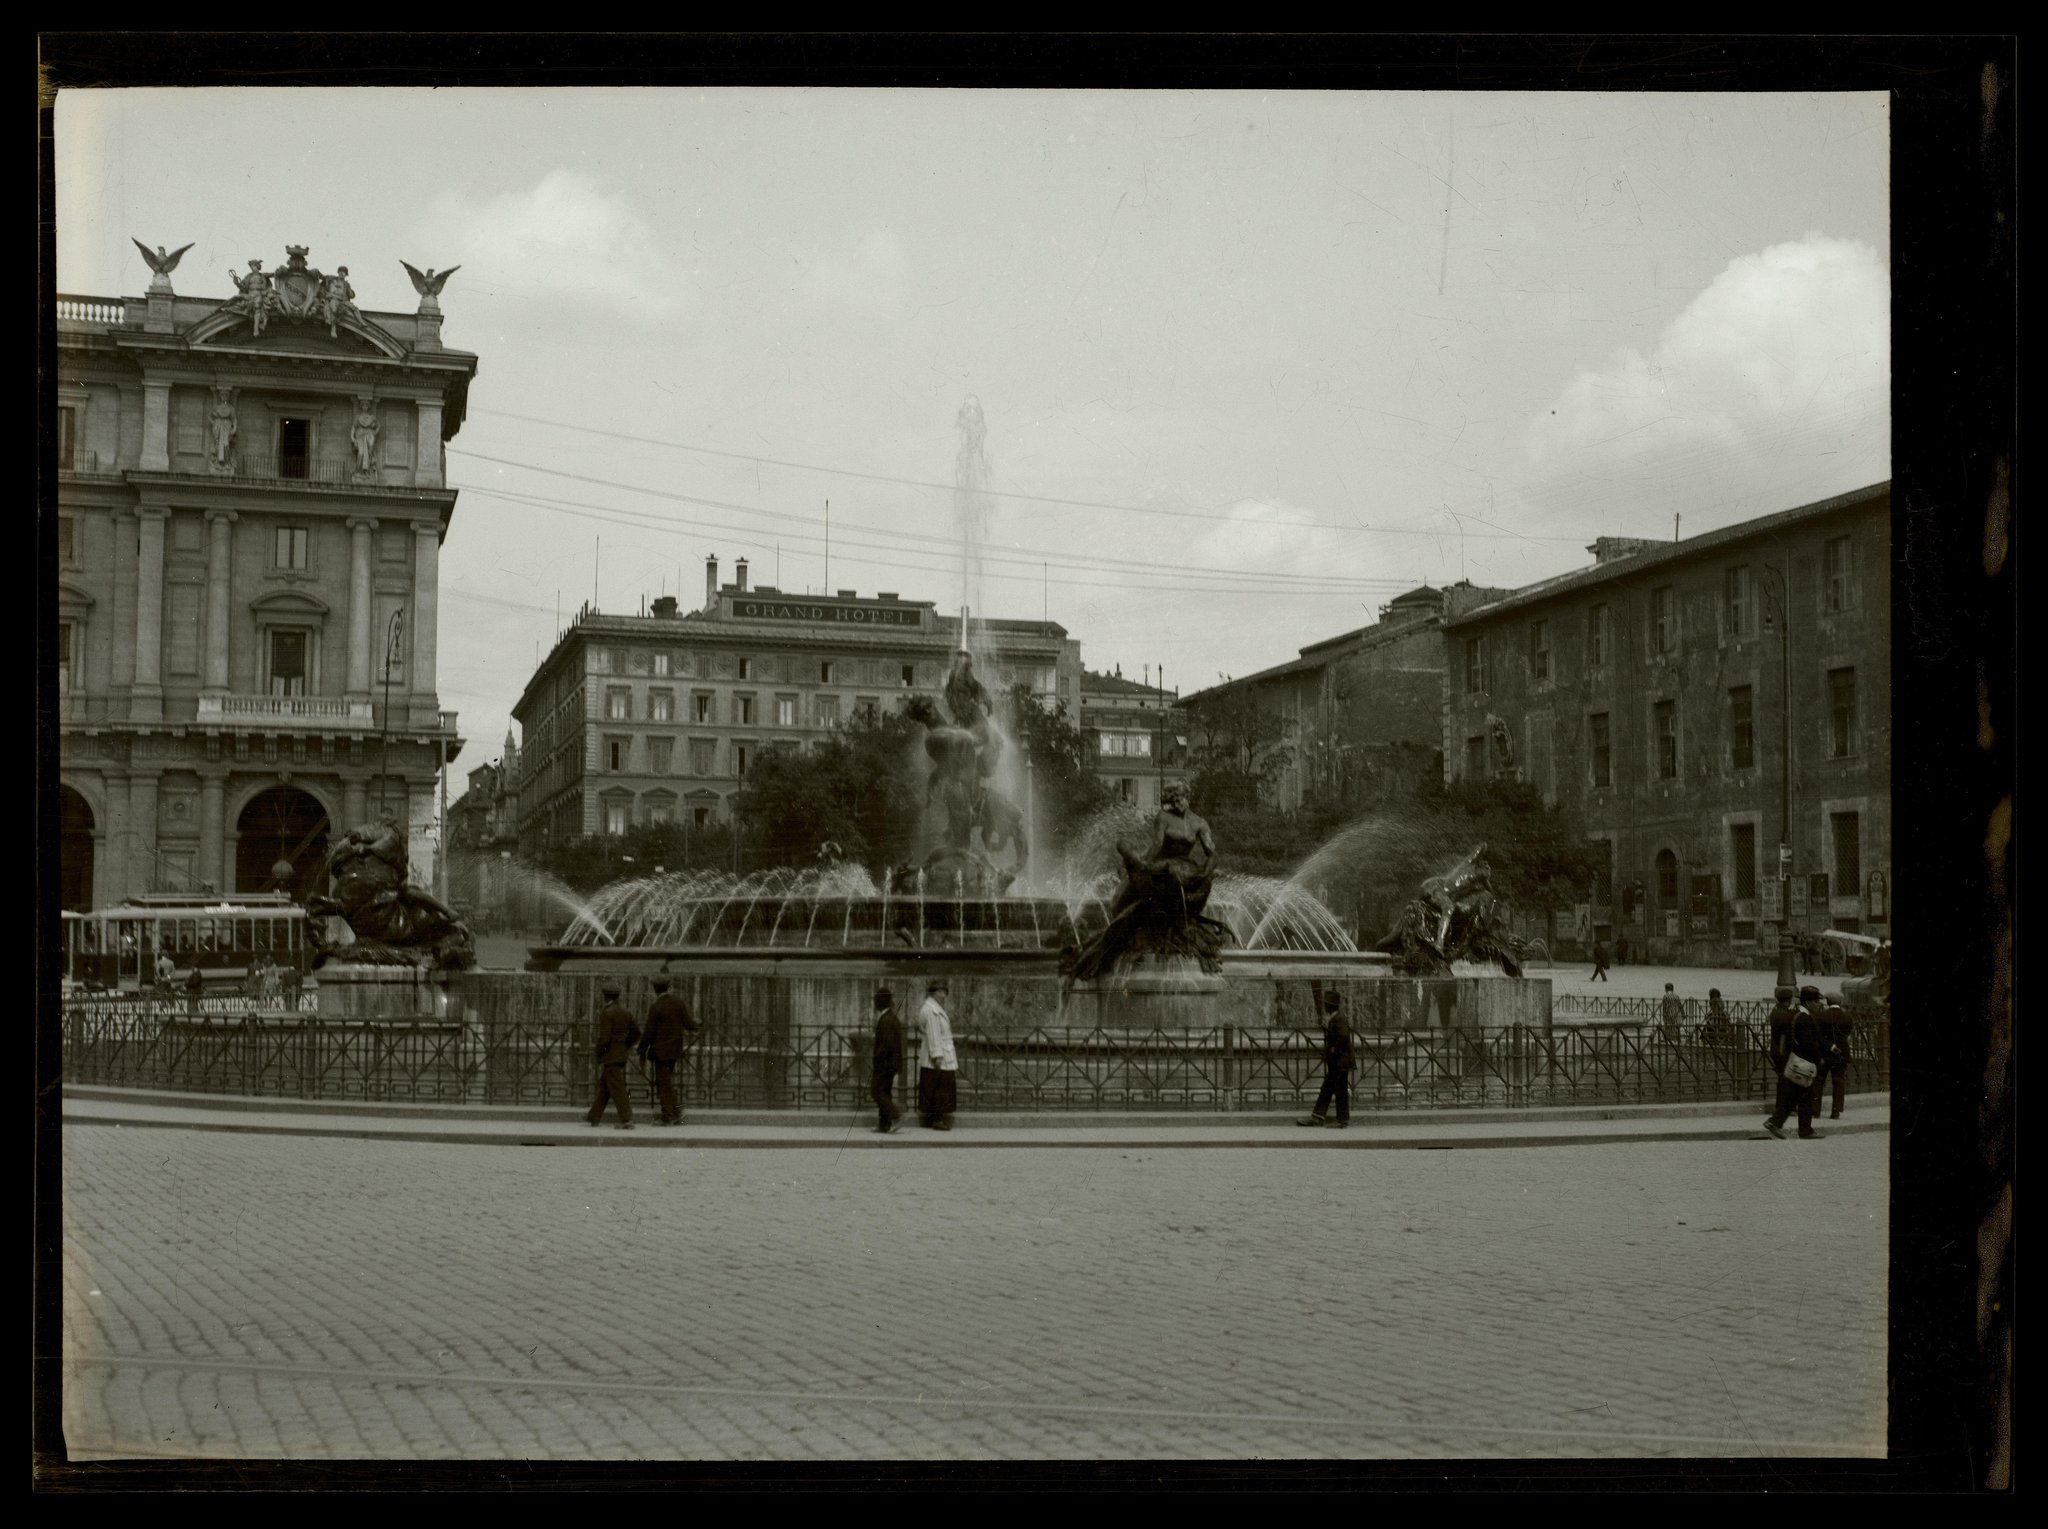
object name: photograph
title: Filmnegatief met opname van Rome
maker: Anonymous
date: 1907-1935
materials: film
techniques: gelatin silver negative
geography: rome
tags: rome